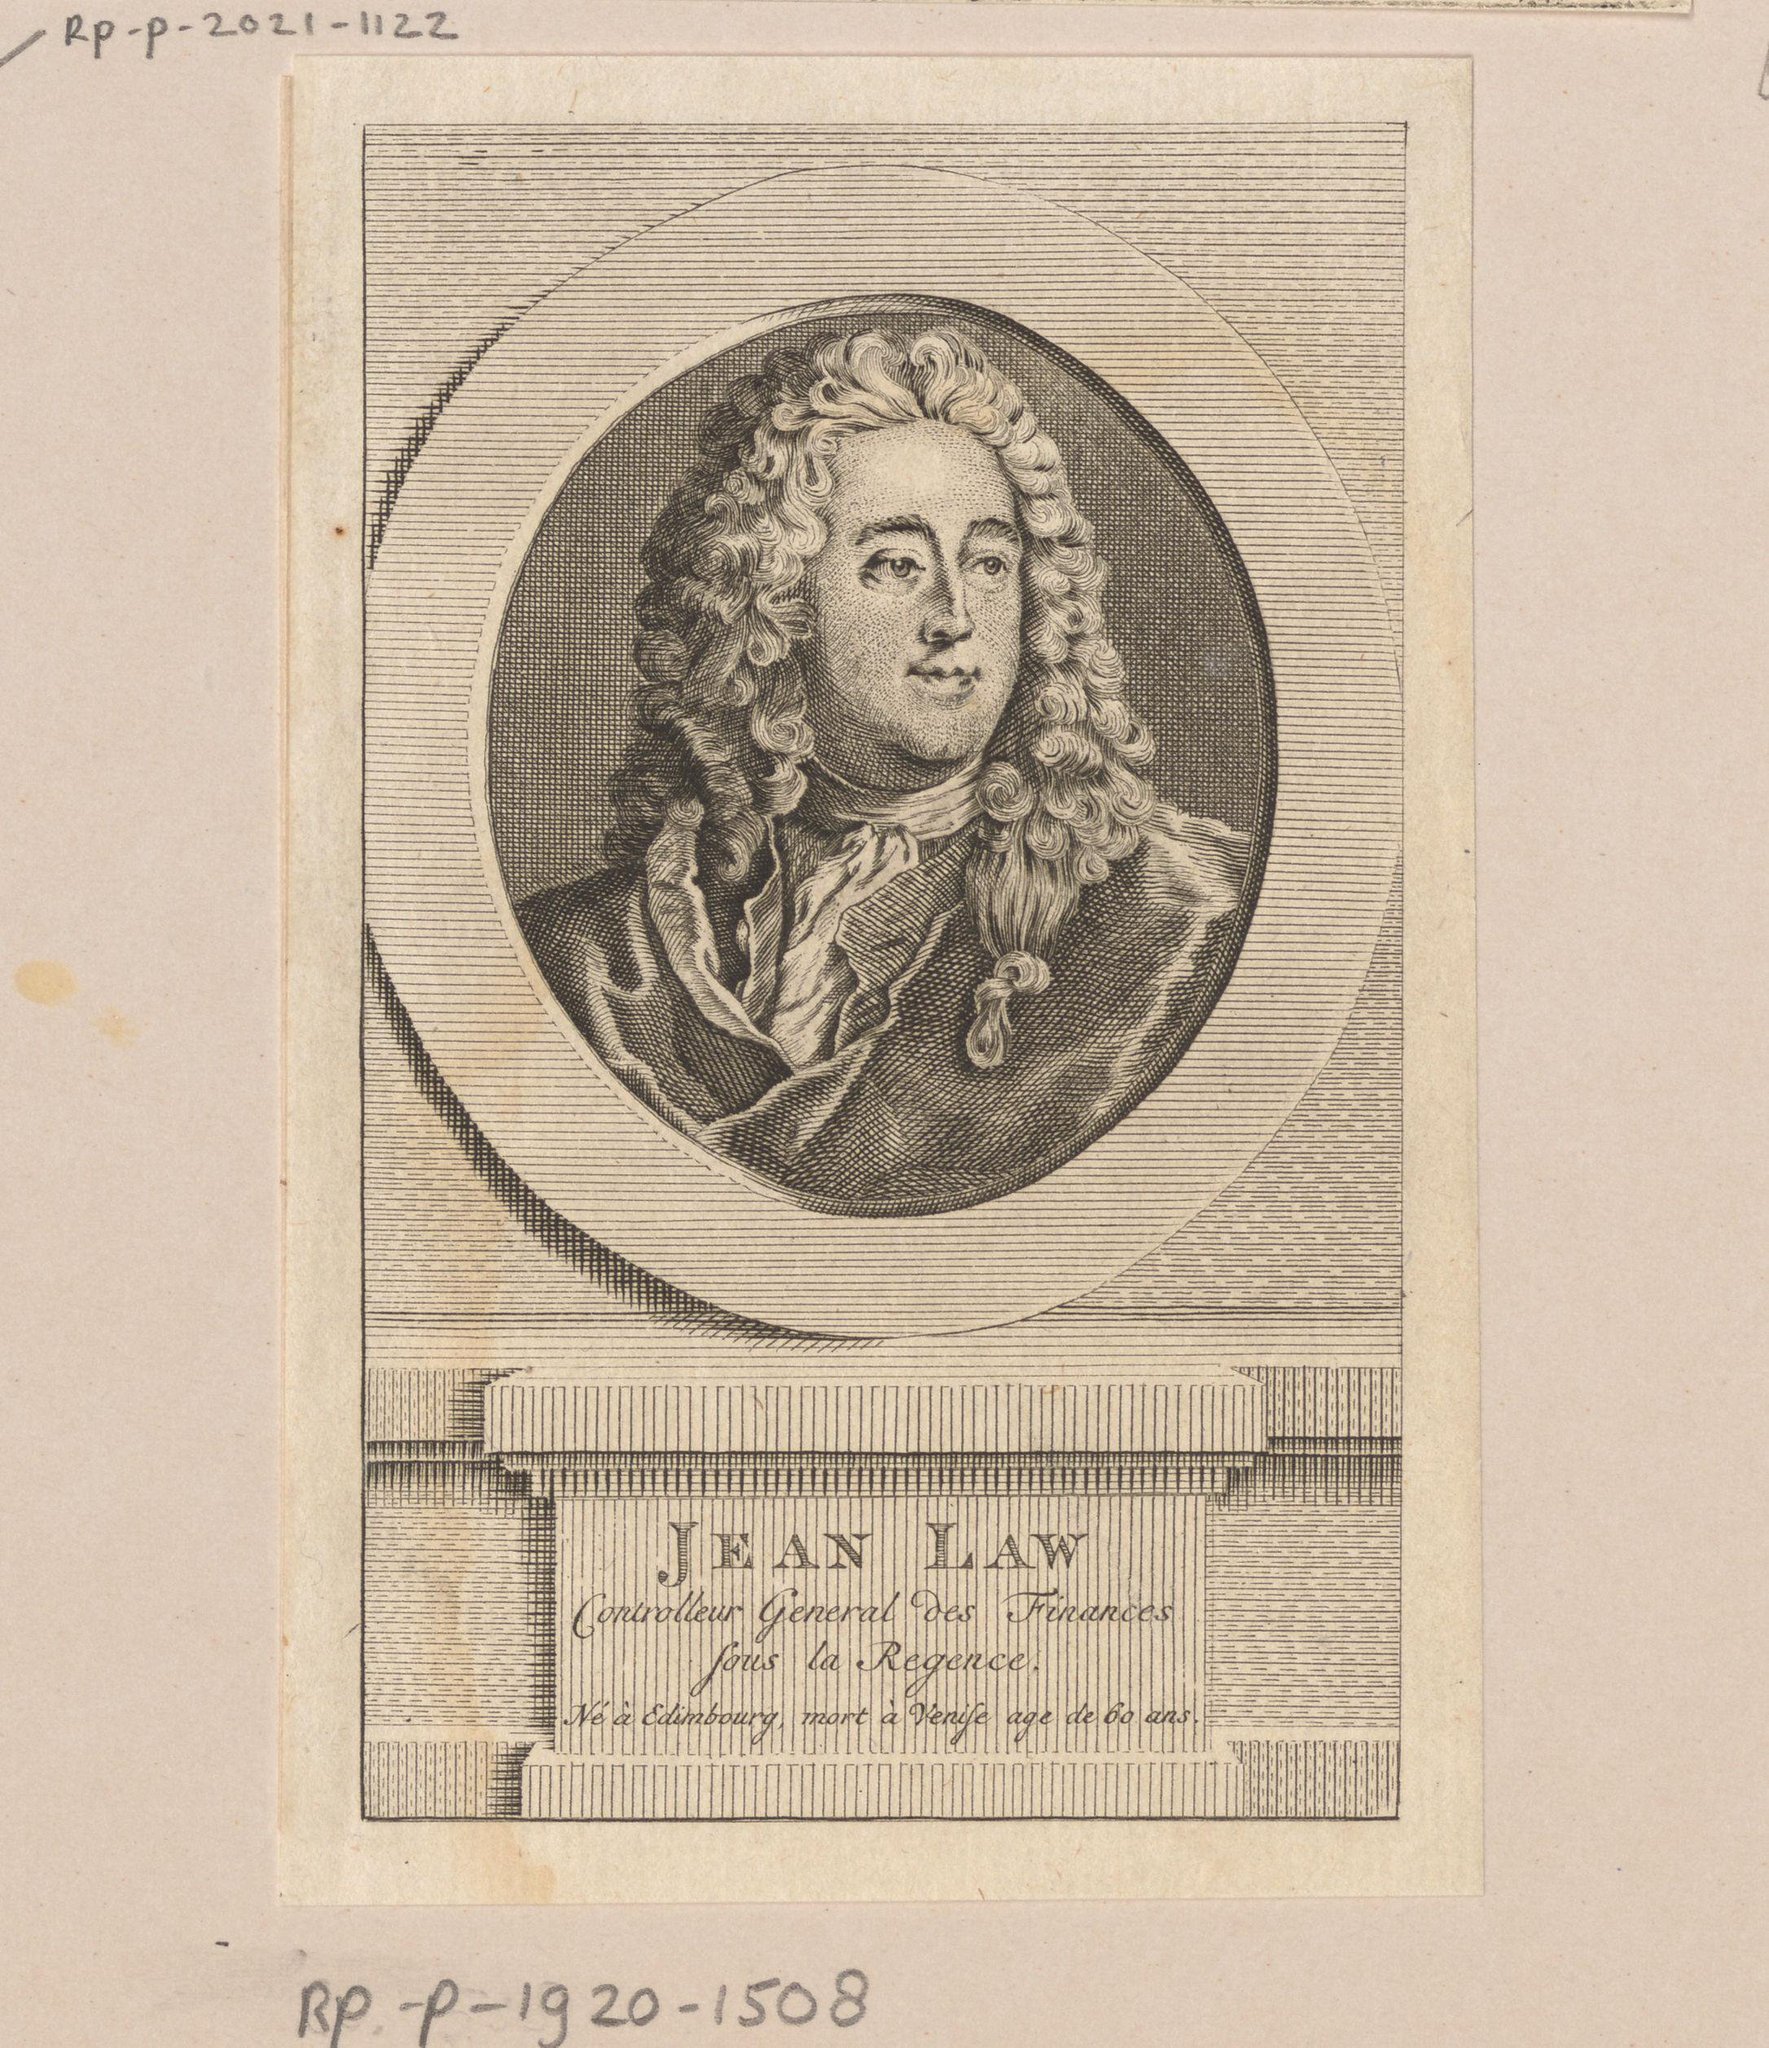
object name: print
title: Portret van John Law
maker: Anonymous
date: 1729-1799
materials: paper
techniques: engraving, etching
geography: france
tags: ornament ~ medallion, historical persons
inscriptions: collector's mark: Lugt 2228